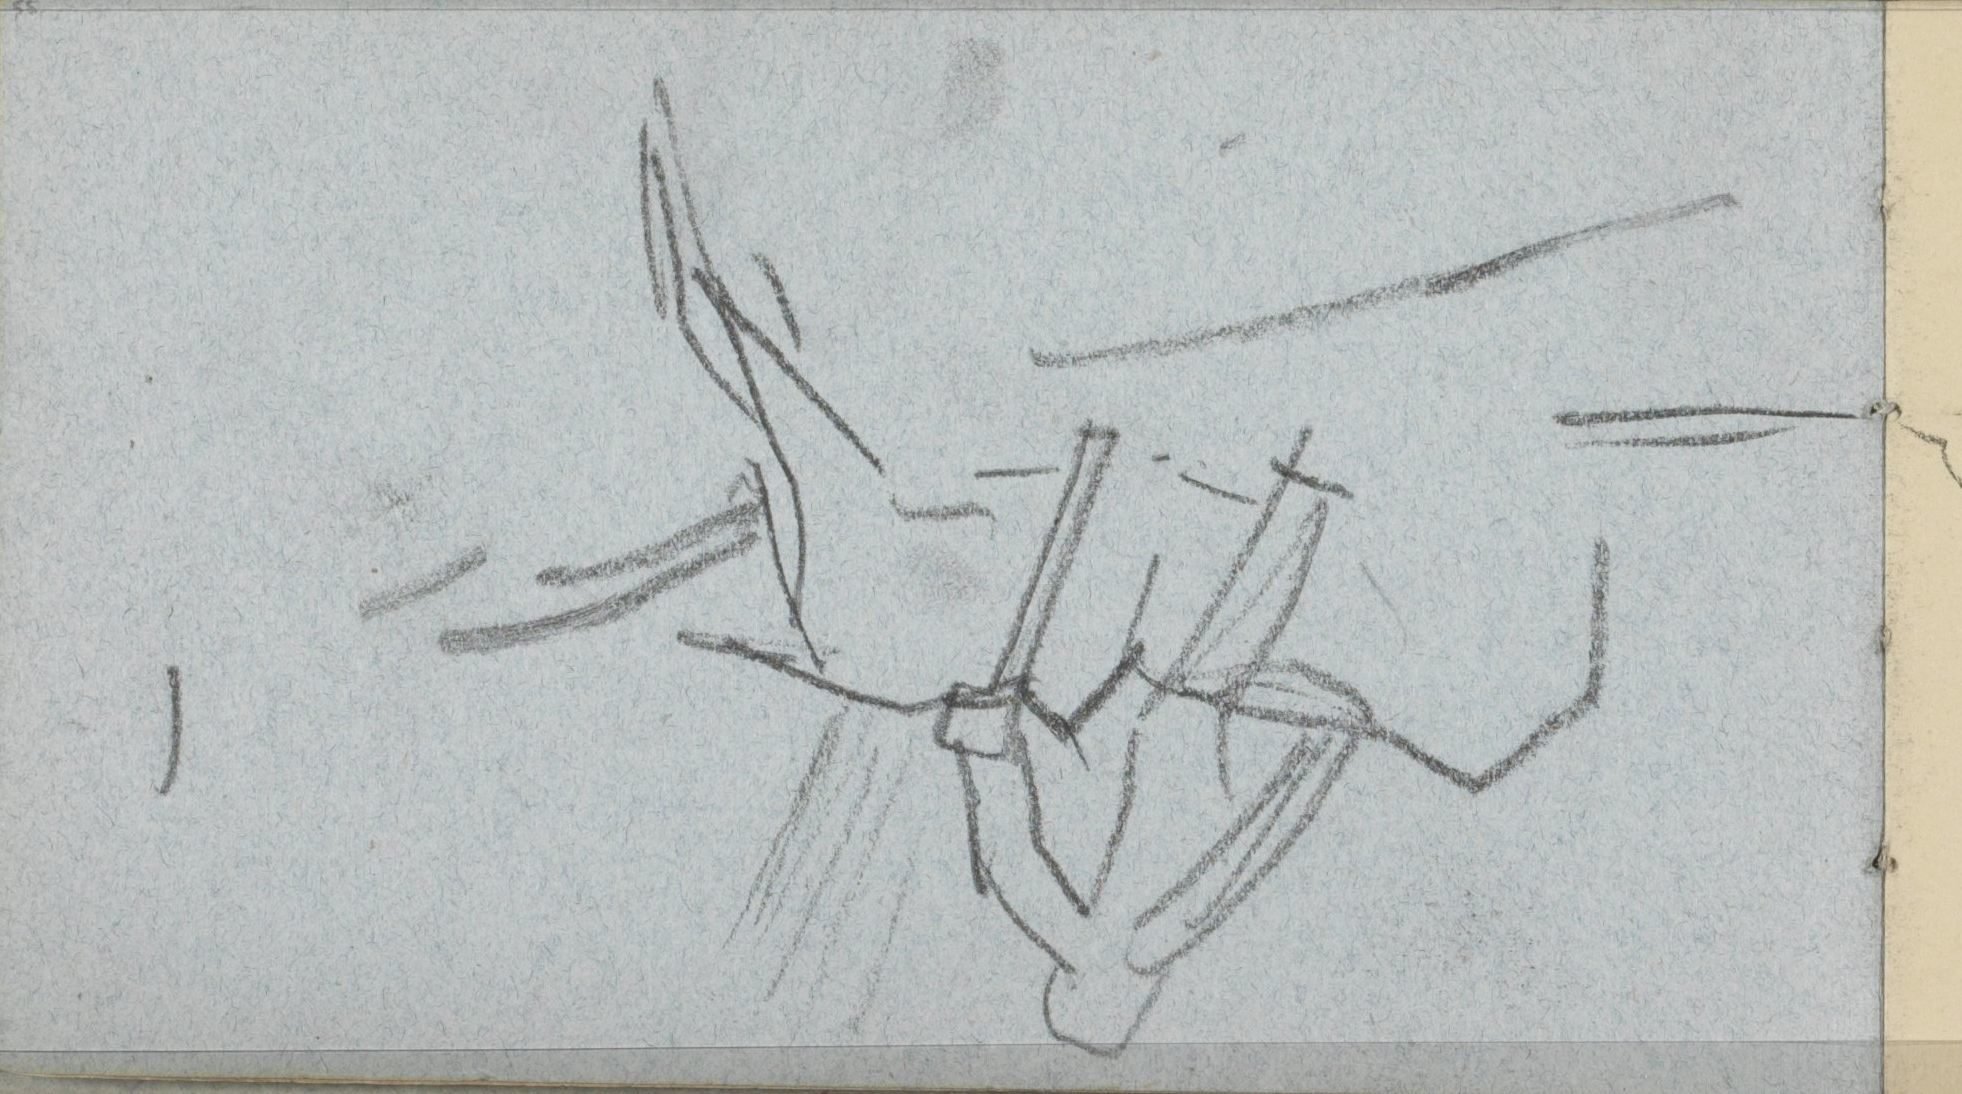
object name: sketchbook leaf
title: Ruiter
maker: george hendrik breitner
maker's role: draughtsman, painter, print maker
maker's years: 1857-1923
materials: chalk, paper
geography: amsterdam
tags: riding a horse, ass, or mule; rider, horseman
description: Pagina 55 uit een schetsboek met 32 bladen.